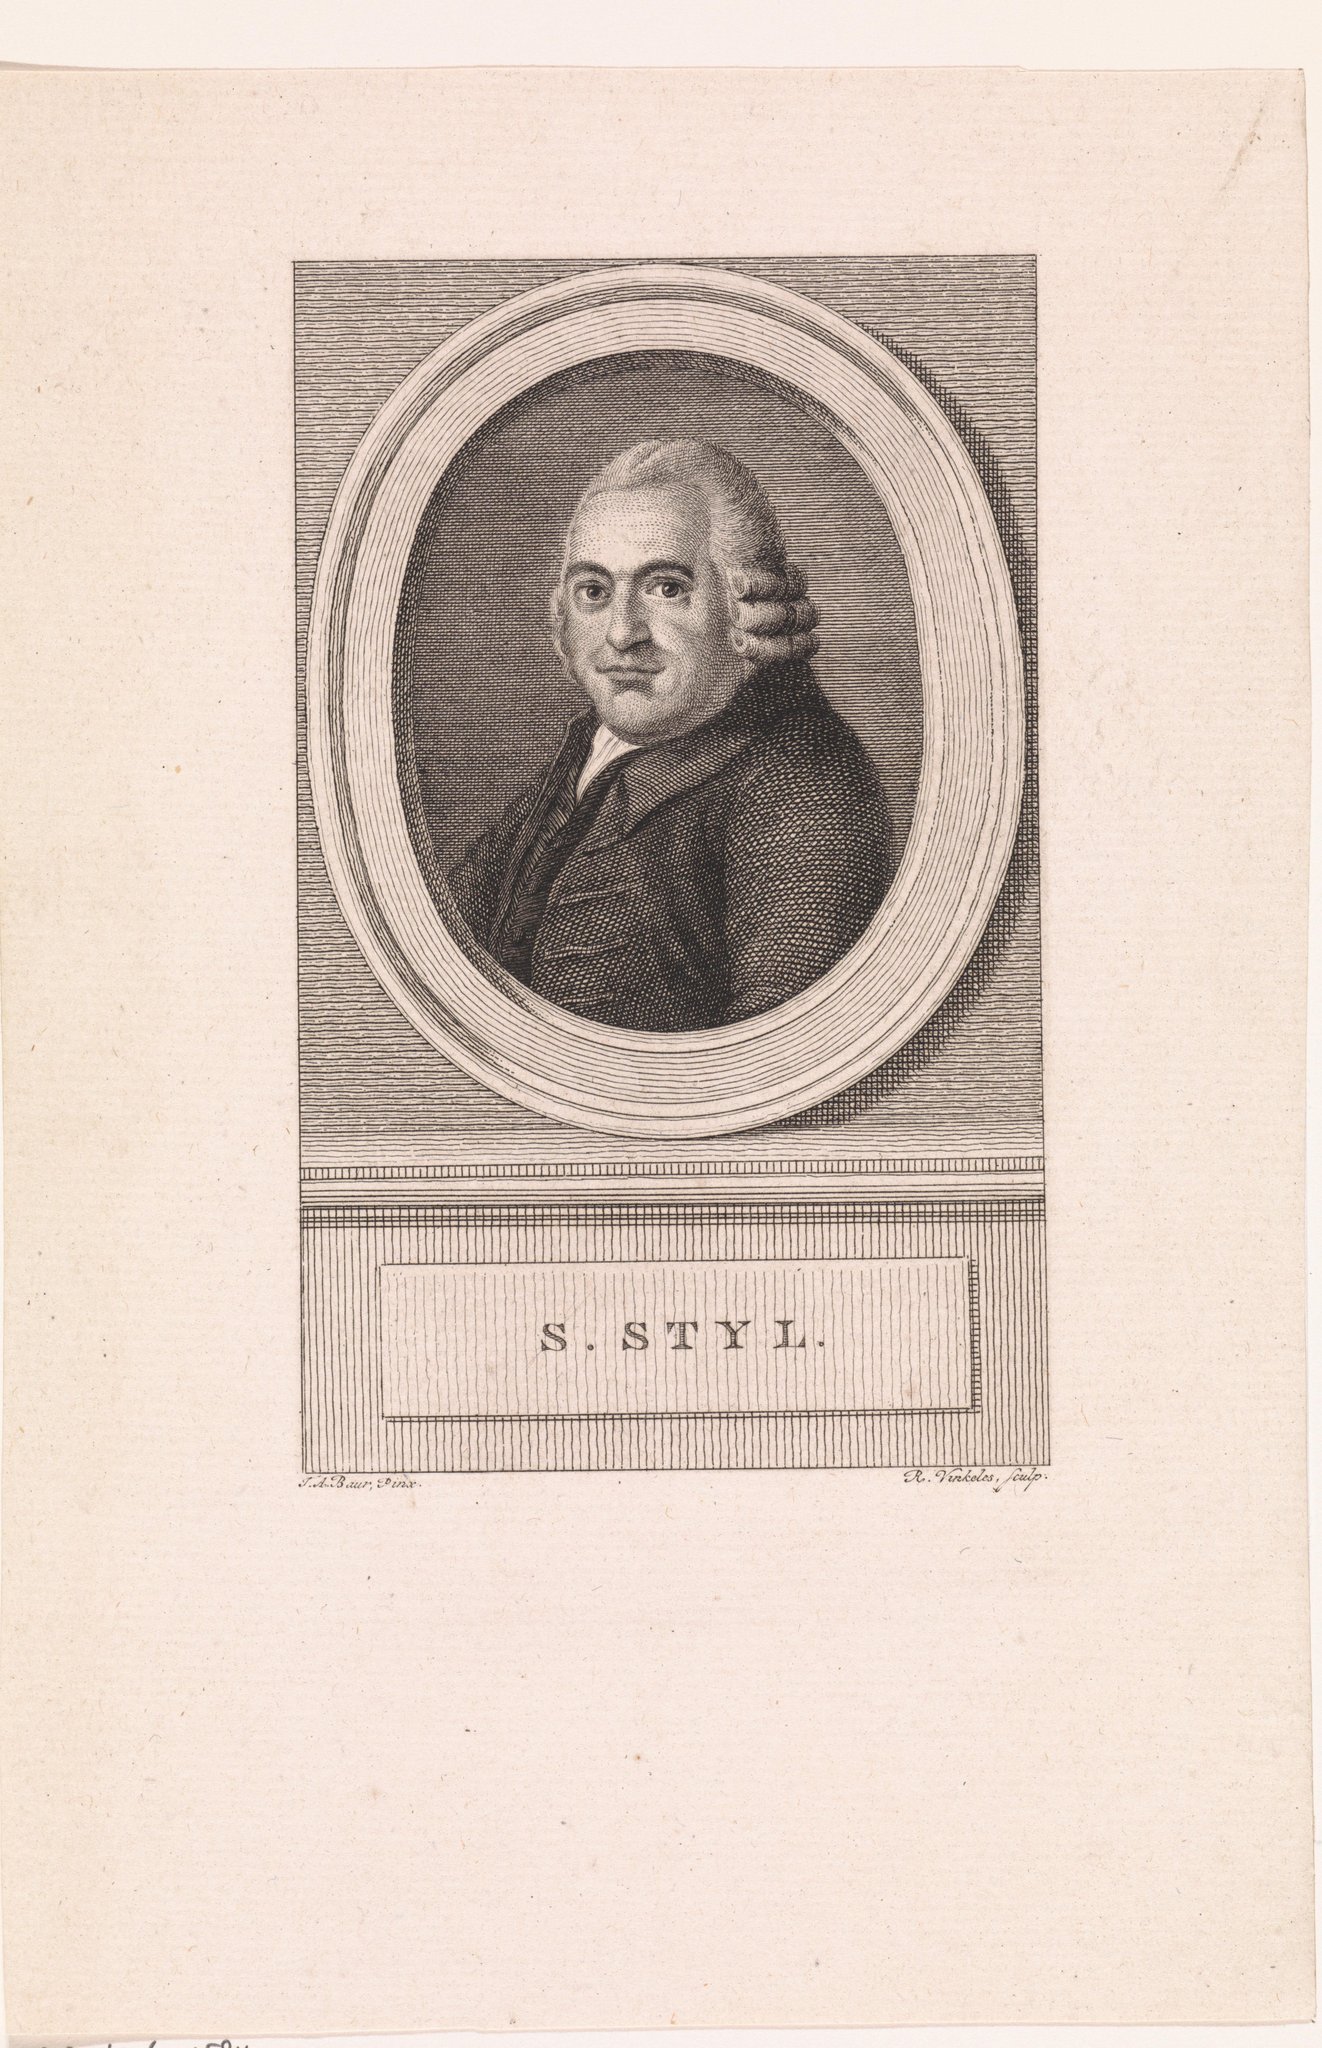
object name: print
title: Portret van Simon Stijl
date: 1786-1809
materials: paper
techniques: engraving, etching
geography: amsterdam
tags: harlingen, simon stijl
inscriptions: collector's mark: Lugt 2228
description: Prent ook gebruikt als boekillustratie in: Wagenaar, Jan. Vaderlandsche historie, (...) ten vervolge van Wagenaars Vaderlandsche historie. Dl. 1-43. Amsterdam: Johannes Allart, 1786-1809.